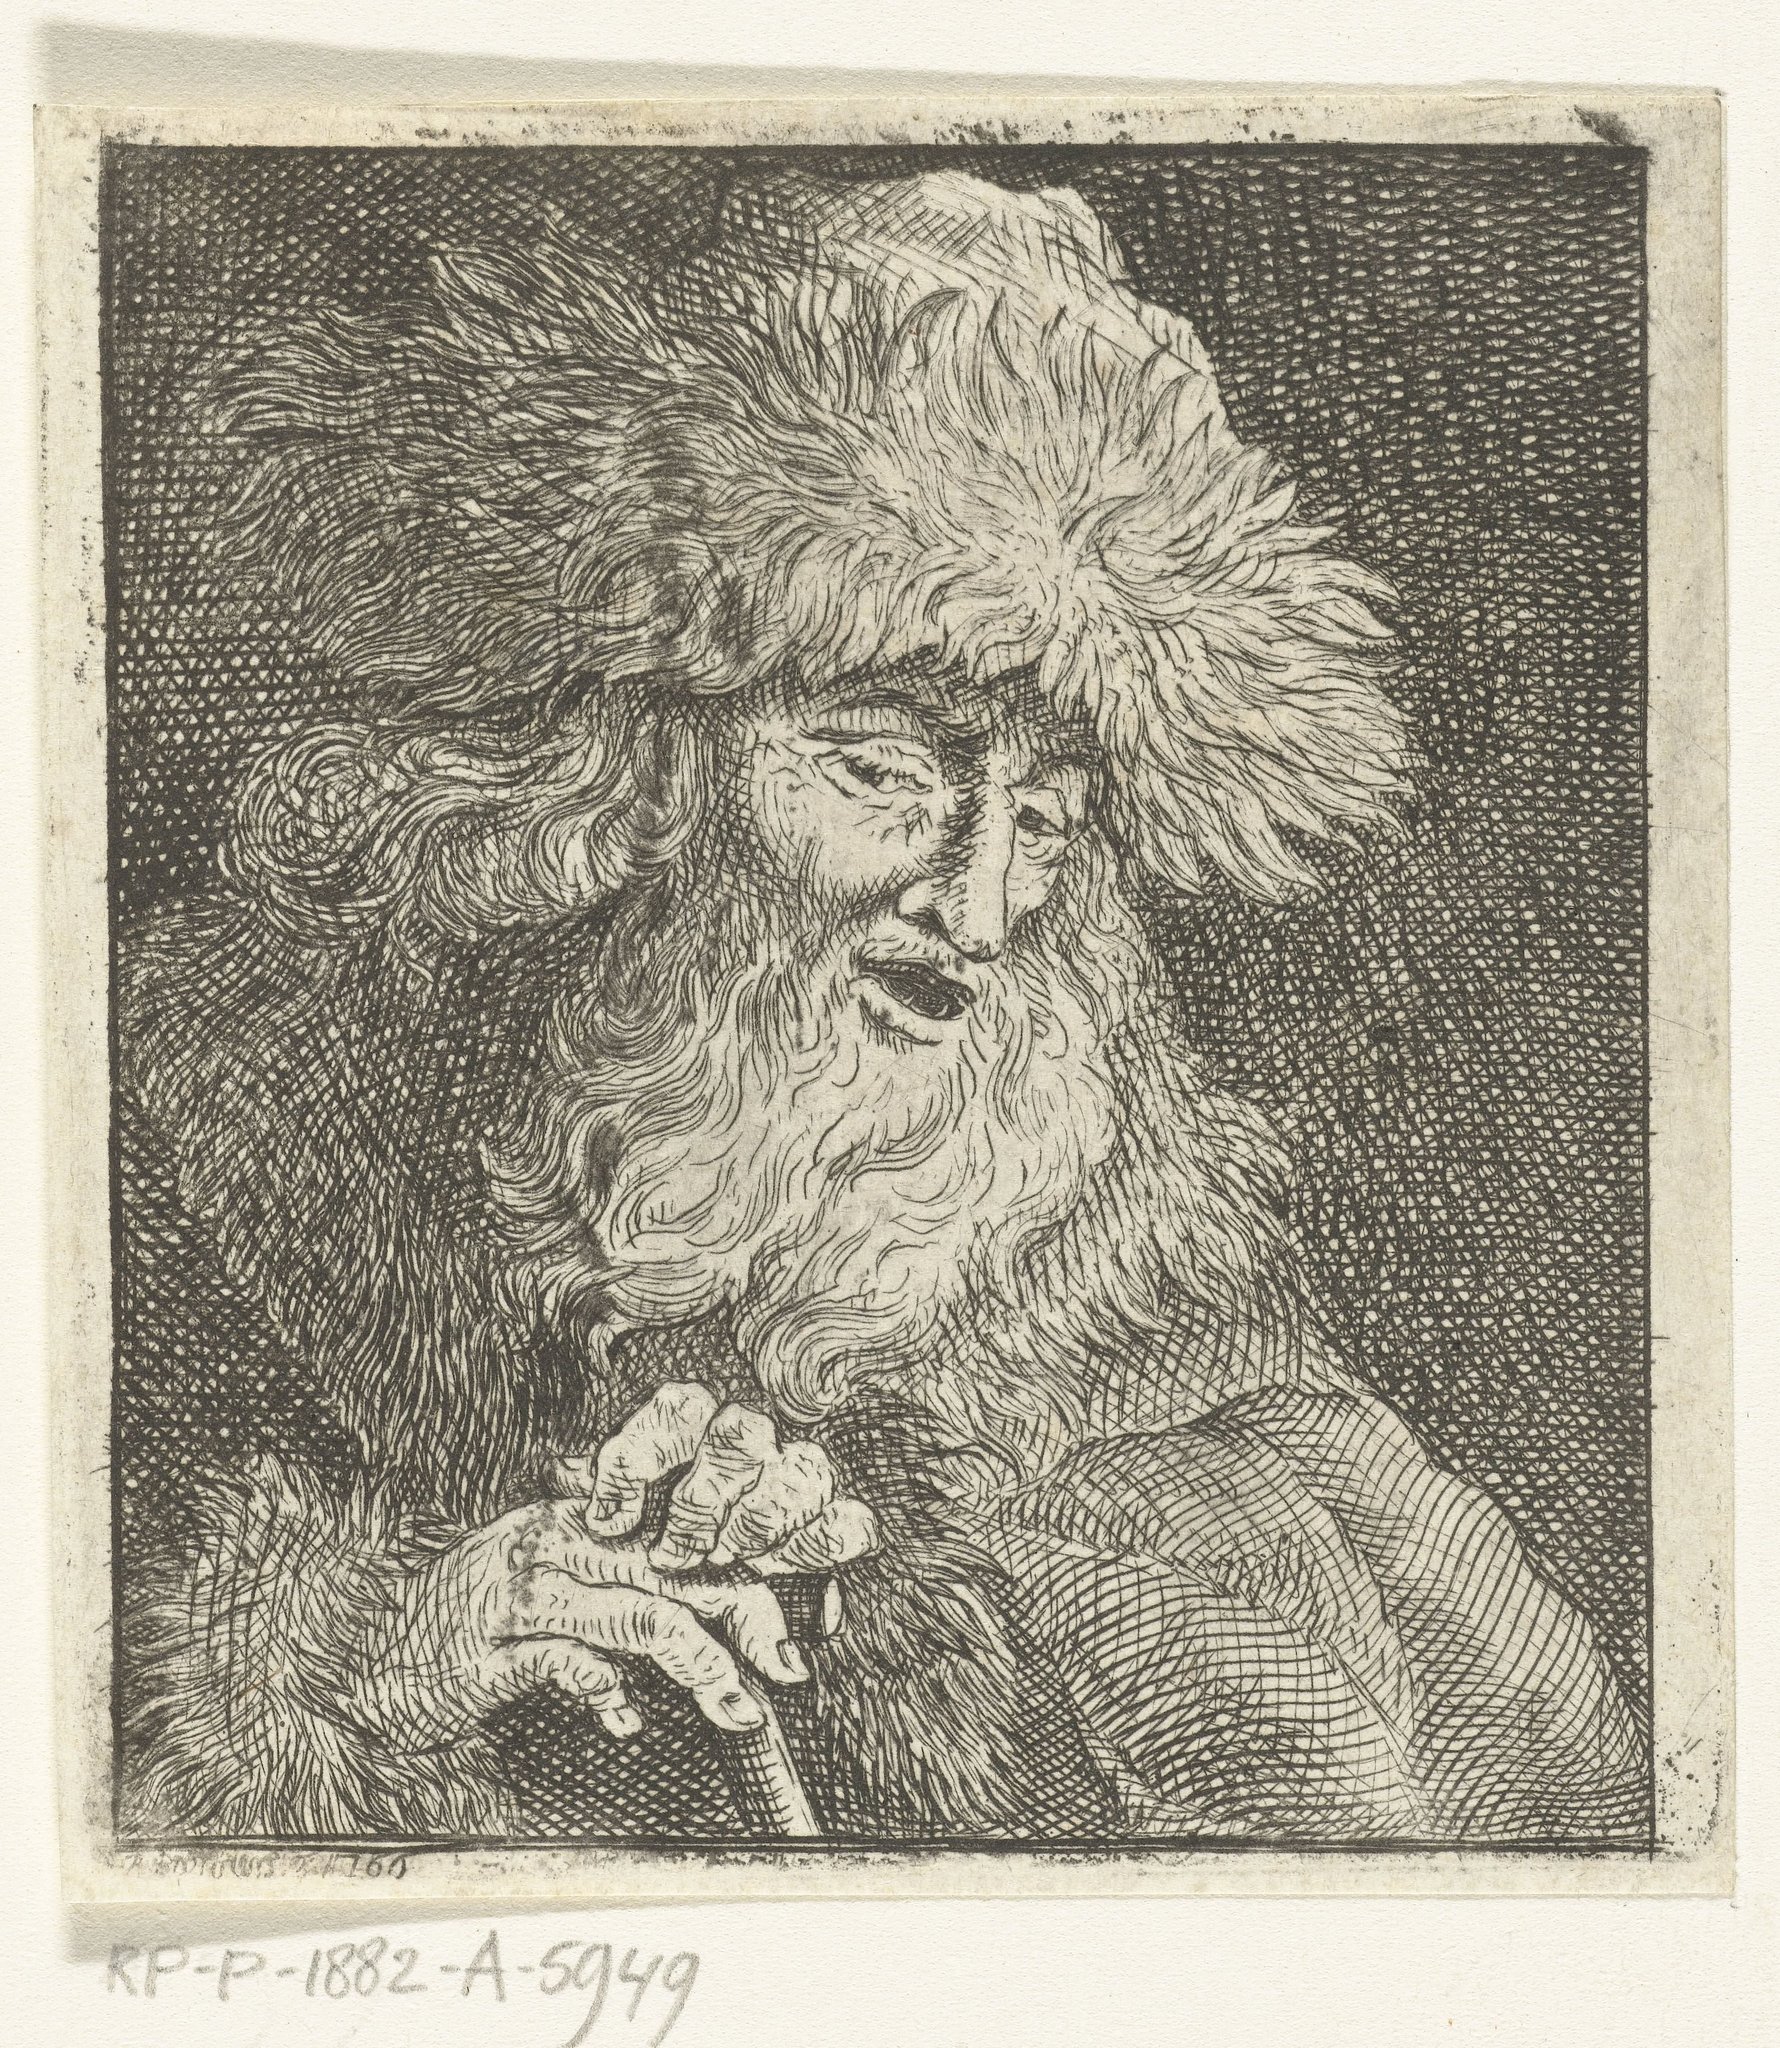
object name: print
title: Oude man met bontmuts en handen rustend op stok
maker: pieter barbiers (i)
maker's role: print maker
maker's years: 1717-1780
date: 1760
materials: paper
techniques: etching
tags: head-gear: cap (+ men's clothes), old man, fashion, clothing (+ fur used for clothes)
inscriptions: collector's mark: Lugt 2228